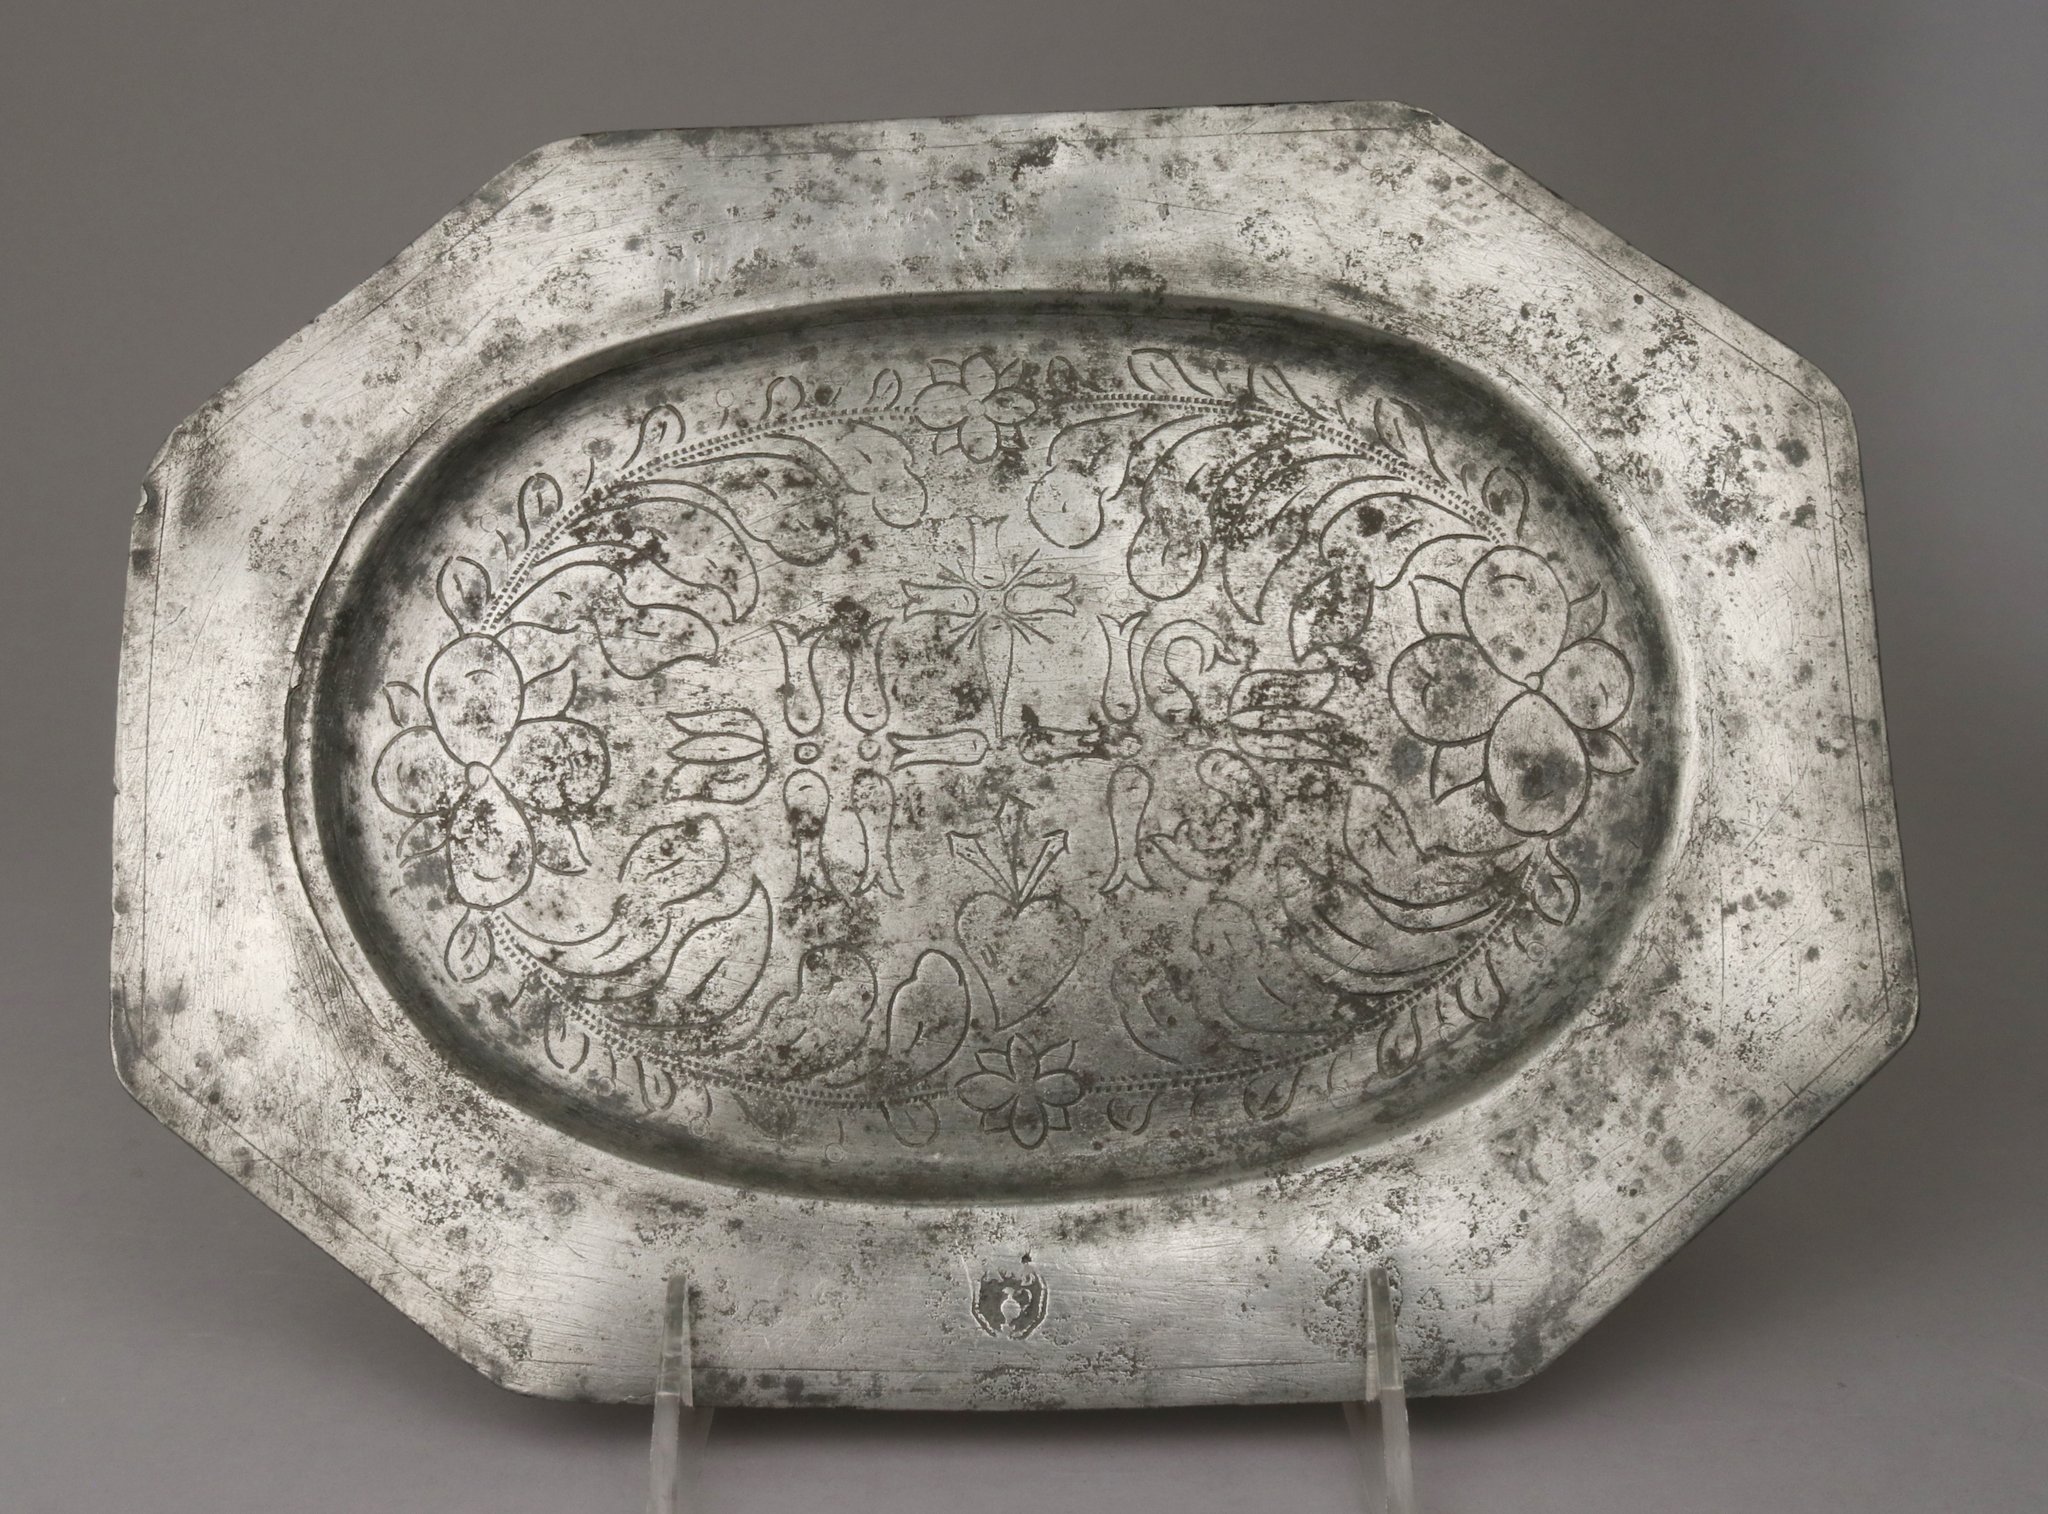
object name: dish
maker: anton i diem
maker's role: maker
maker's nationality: austrian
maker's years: 1700-1744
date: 1734-1766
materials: pewter